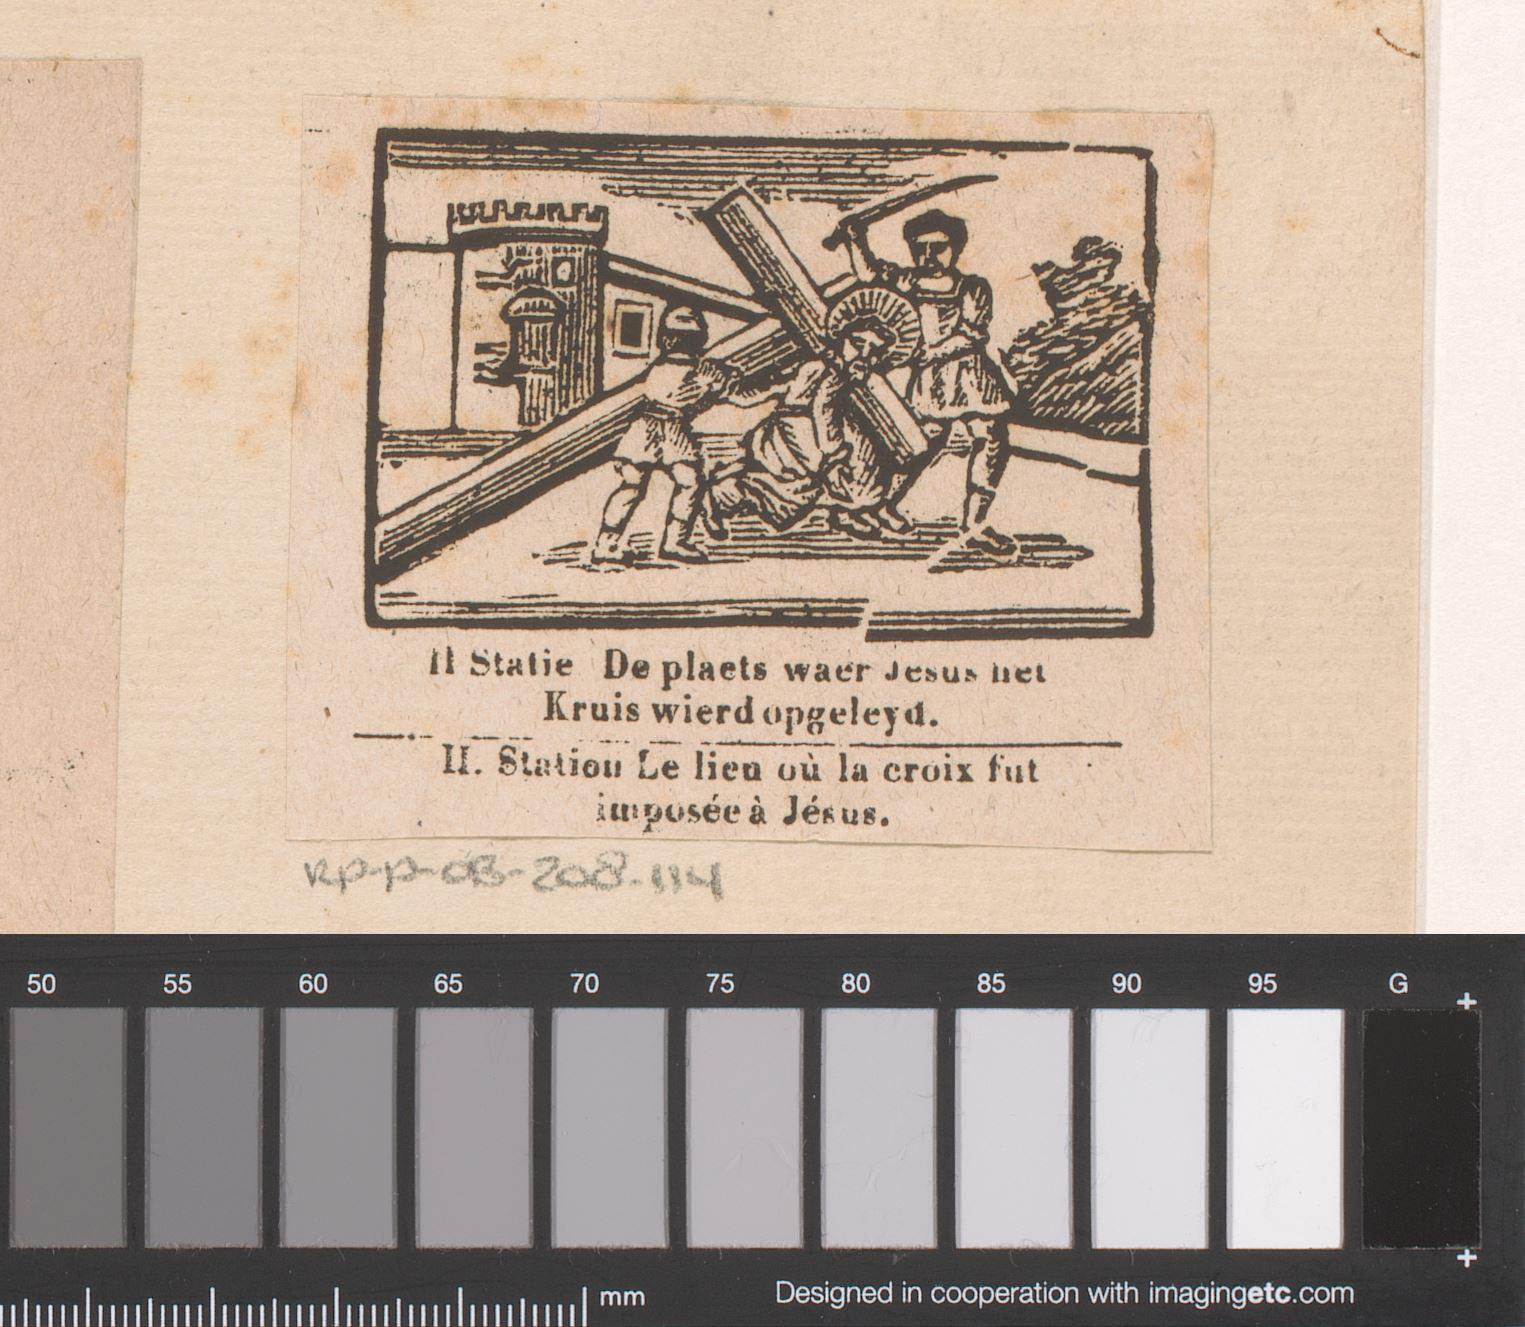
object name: print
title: Kruiswegstatie 2: Kruisdraging van Christus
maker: Anonymous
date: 1600-1699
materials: paper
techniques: letterpress printing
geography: netherlands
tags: the 14 franciscan stations of the cross (2), carrying of the cross: christ bearing the cross, alone or with the help of others (e.g. simon the cyrenian)